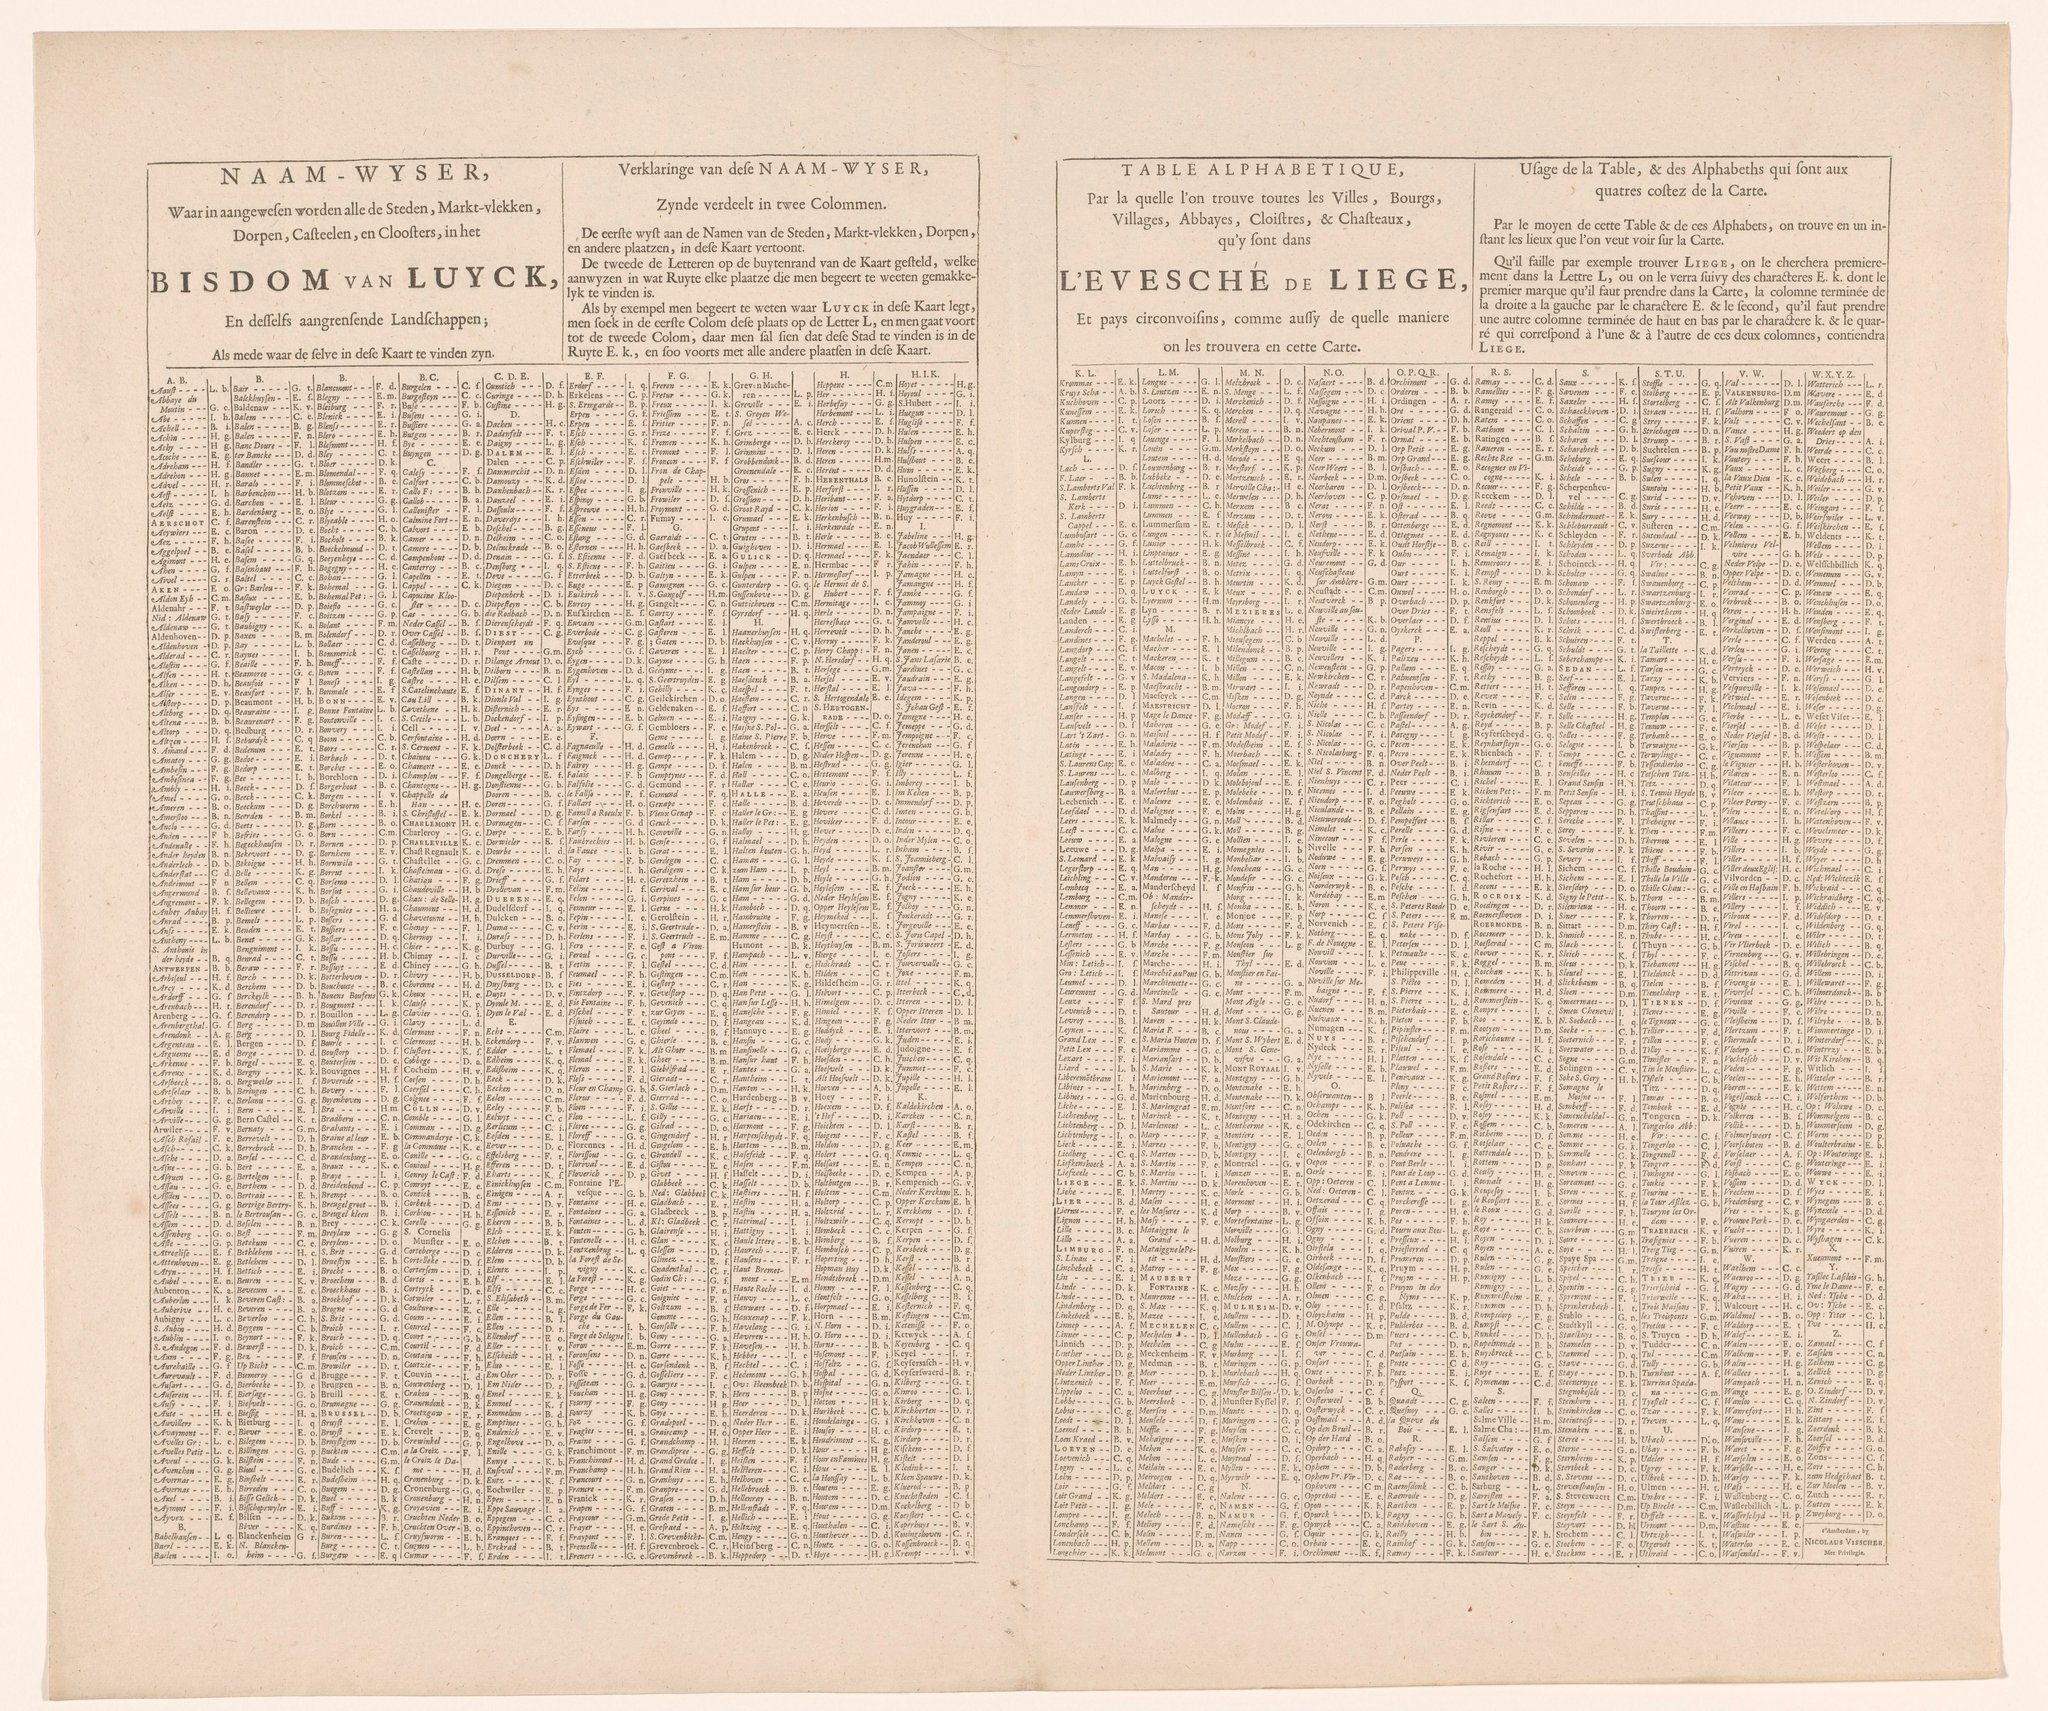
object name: text sheet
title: Naam-wyser waar in aangewesen worden alle de steden (...) / Table Alphabetique par la quelle 'on trouve toutes les Villes (...)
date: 1677-1720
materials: paper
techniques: letterpress printing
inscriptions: collector's mark: Lugt 2228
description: Plaatsregister van alle dorpen en steden die te vinden zijn op de bijhorende kaart. Naast de plaatsnamen staat aangegeven waar de plaatsen met behulp van het zoekrooster op de kaart gevonden kunnen worden.